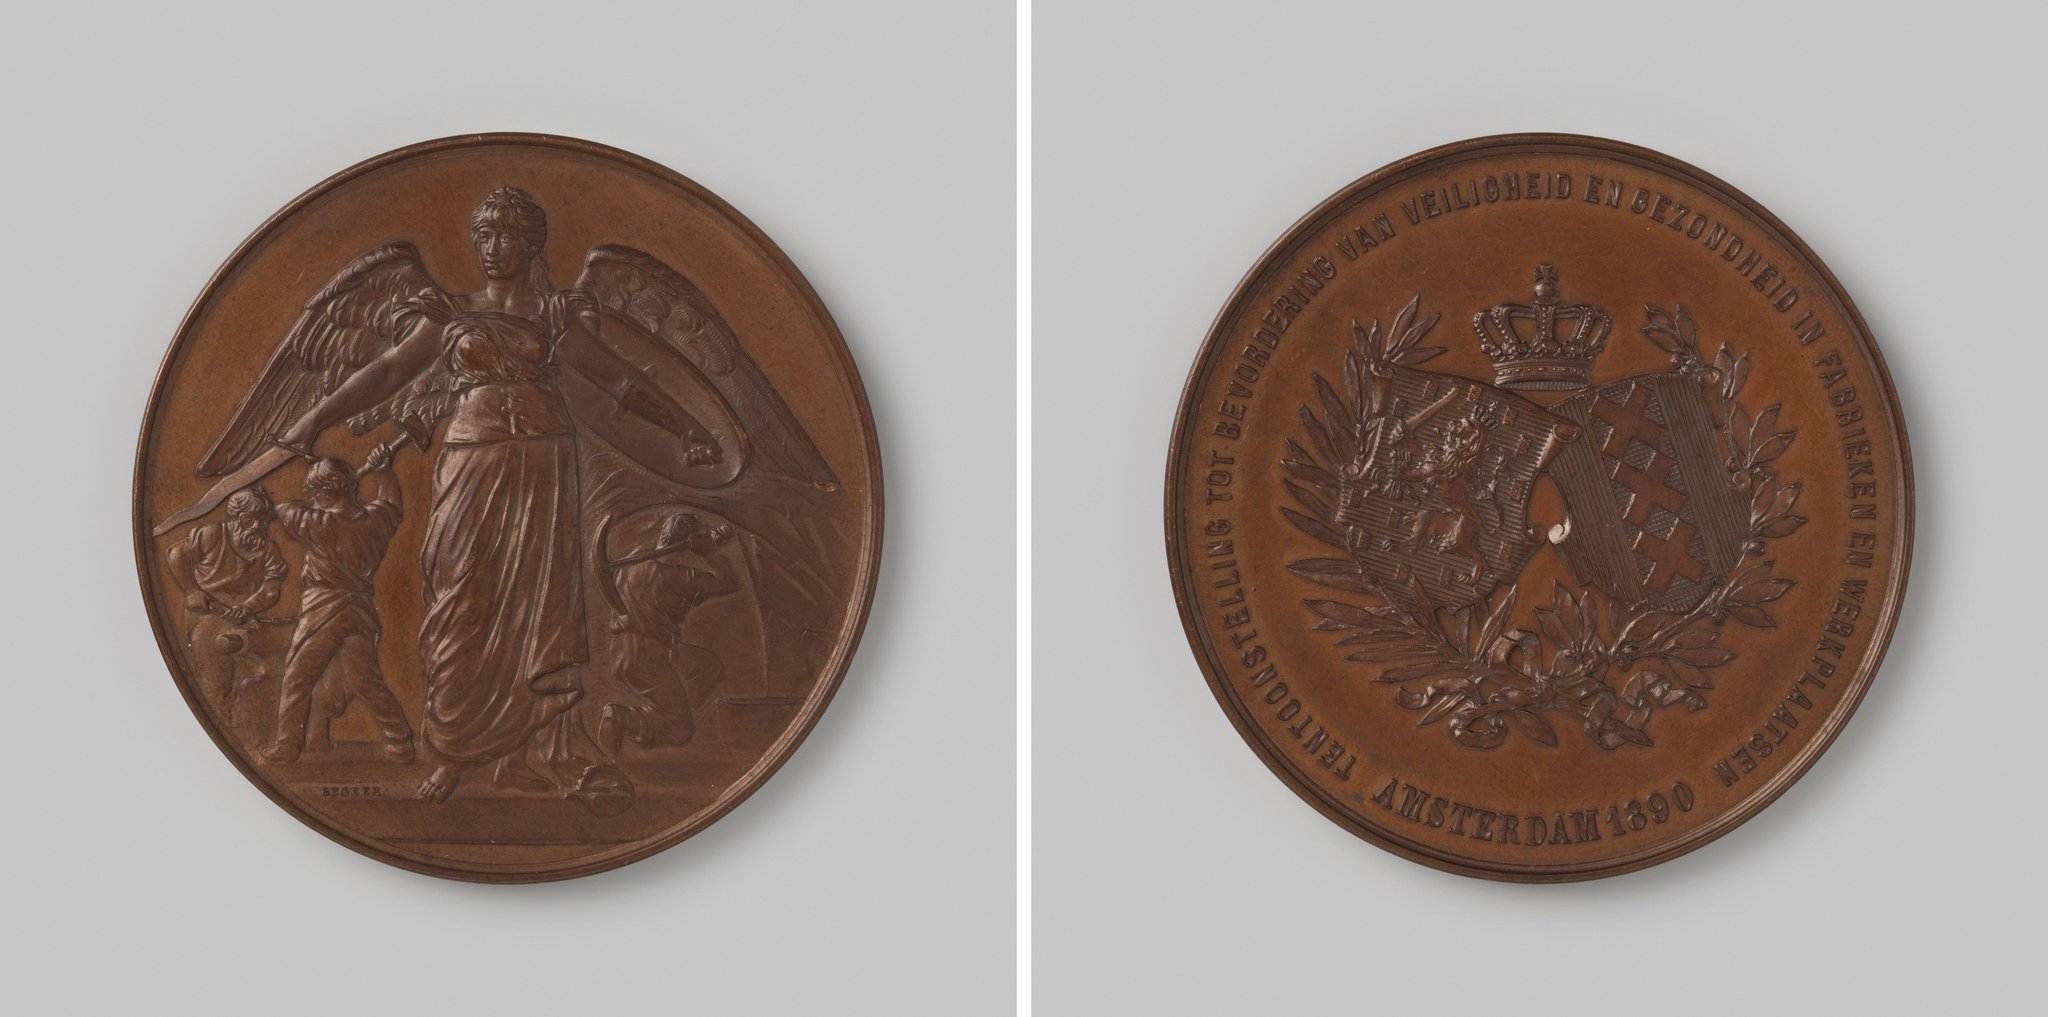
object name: history medal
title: Tentoonstelling tot Bevordering van Veiligheid en Gezondheid in Fabrieken en Werkplaatsen te Amsterdam 1890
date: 1889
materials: bronze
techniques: striking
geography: utrecht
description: Bronzen penning, op de voorzijde een gevleugelde vrouw met zwaard en schild tussen drie arbeiders, op de keerzijde de wapenschilden van Nederland en Amsterdam onder één kroon op samengestrikte lauwertakken, met omschrift.